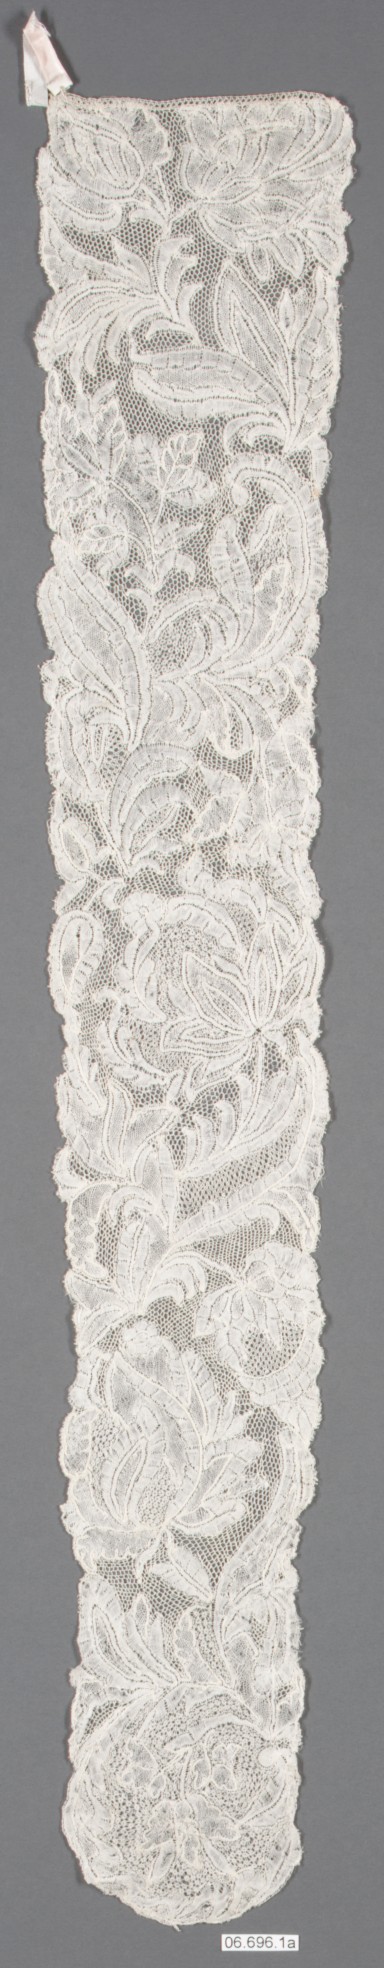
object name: lappet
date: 1700